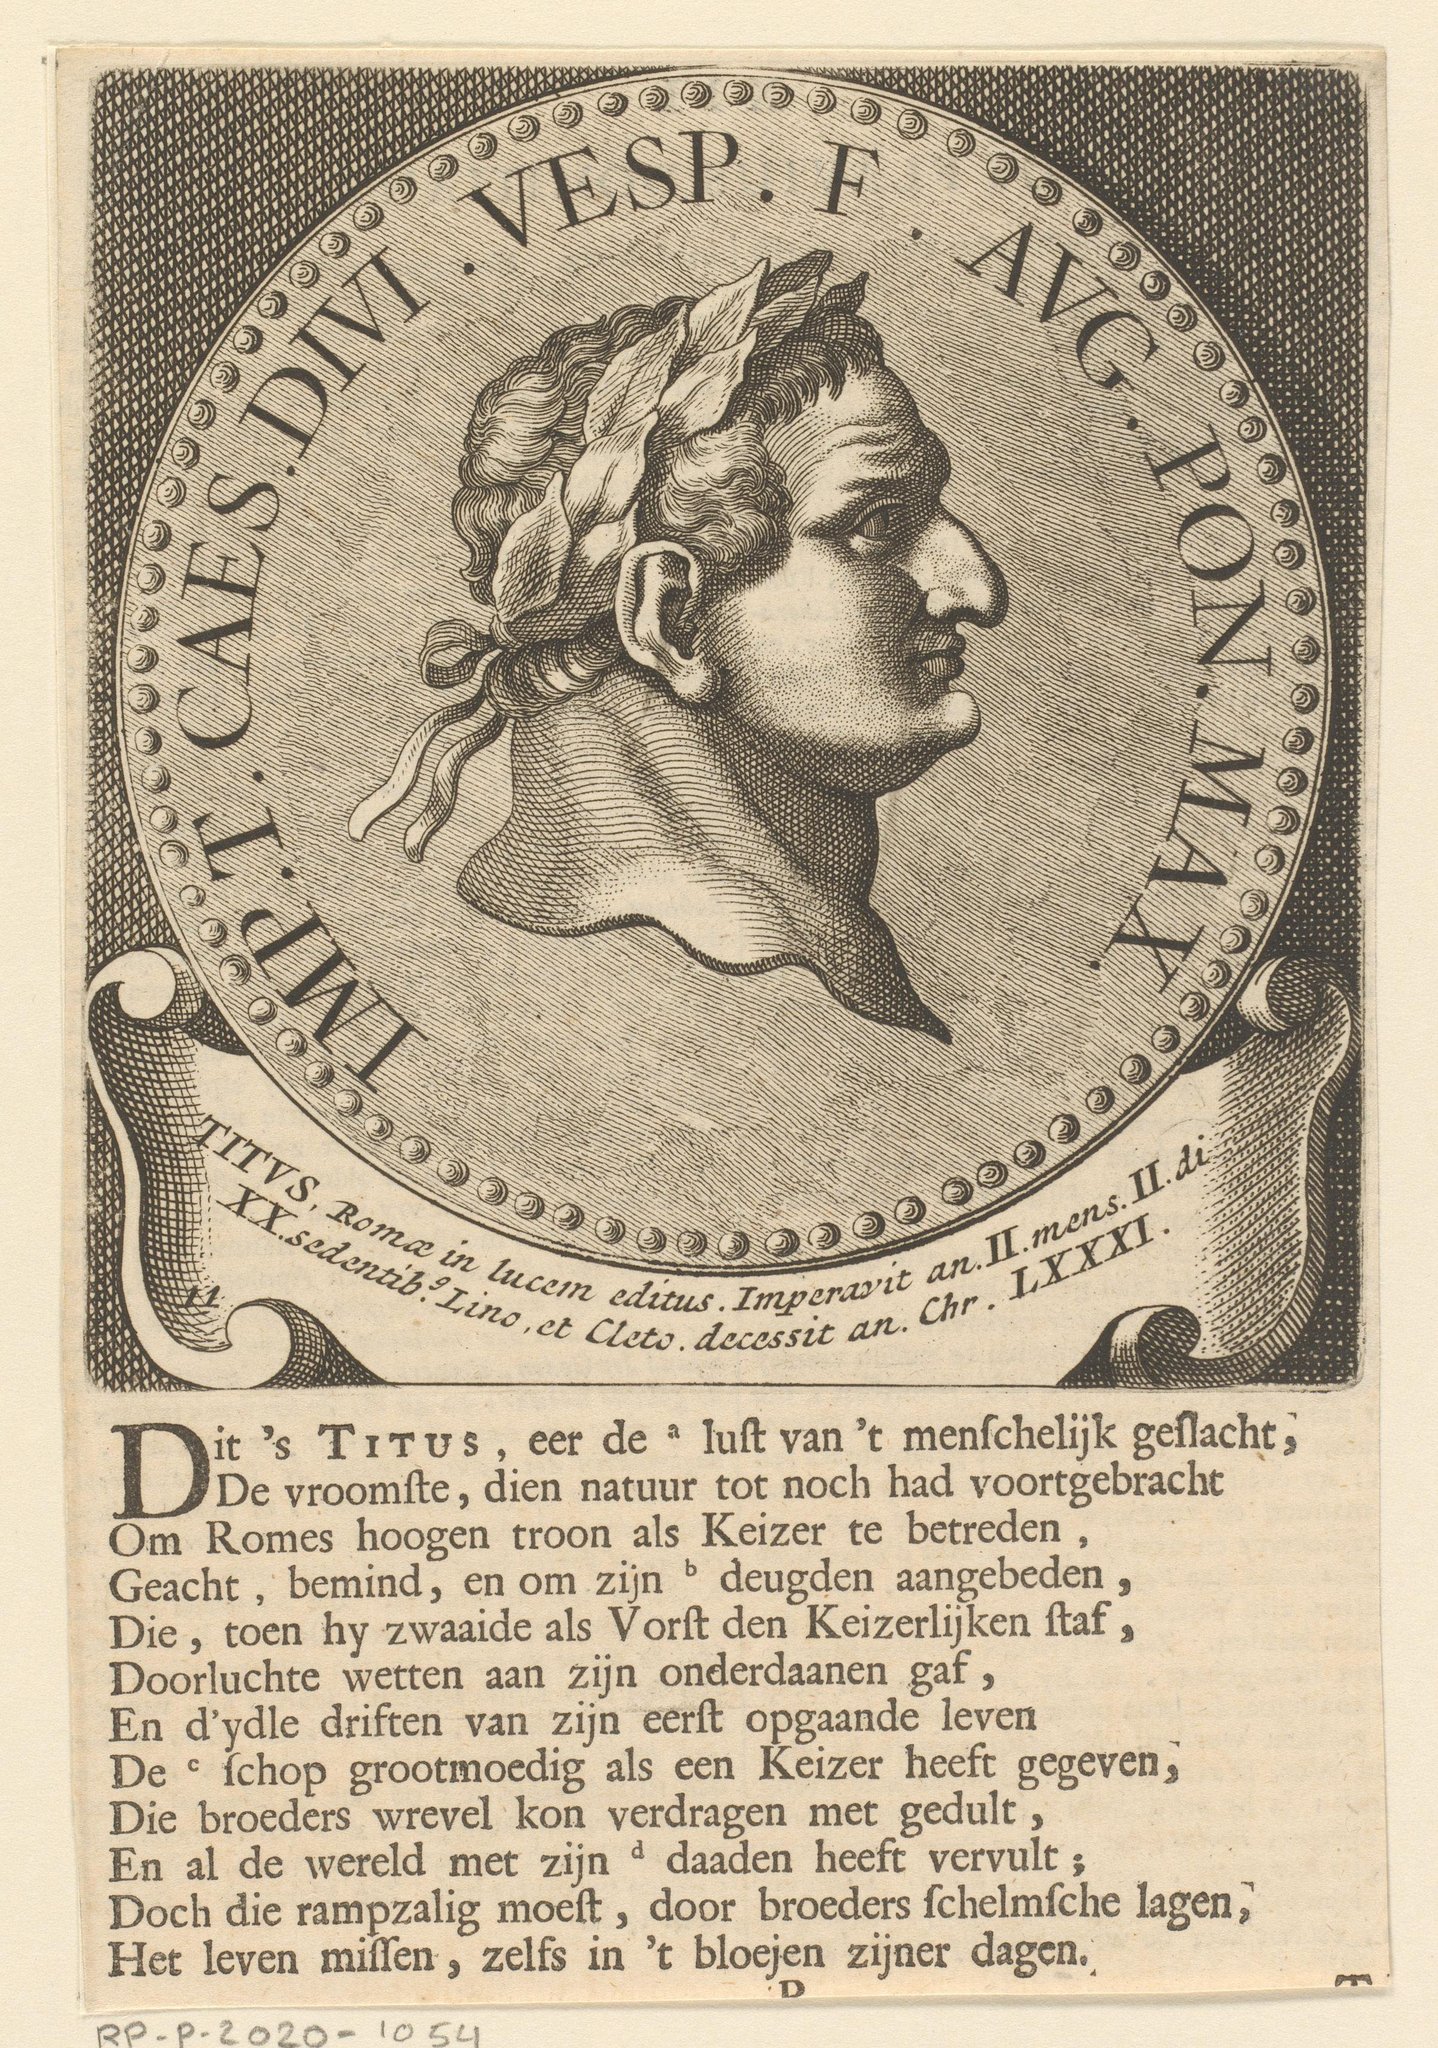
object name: book illustration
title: Titus, Romae in lucem editus (...)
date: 1697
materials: paper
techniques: engraving, etching, letterpress printing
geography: utrecht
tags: (story of) the emperor titus - portrait of person from classical history, historical persons, emperor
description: Prent uit: Bogaert, Abraham. De Roomsche monarchy, vertoont in de muntbeelden der westersche en oostersche keizeren (...). Utrecht: François Halma en Willem van de Water, 1697, p. 129. Eerste staat verschenen in een grotere prent met twaalf portretten, gedateerd 1695.